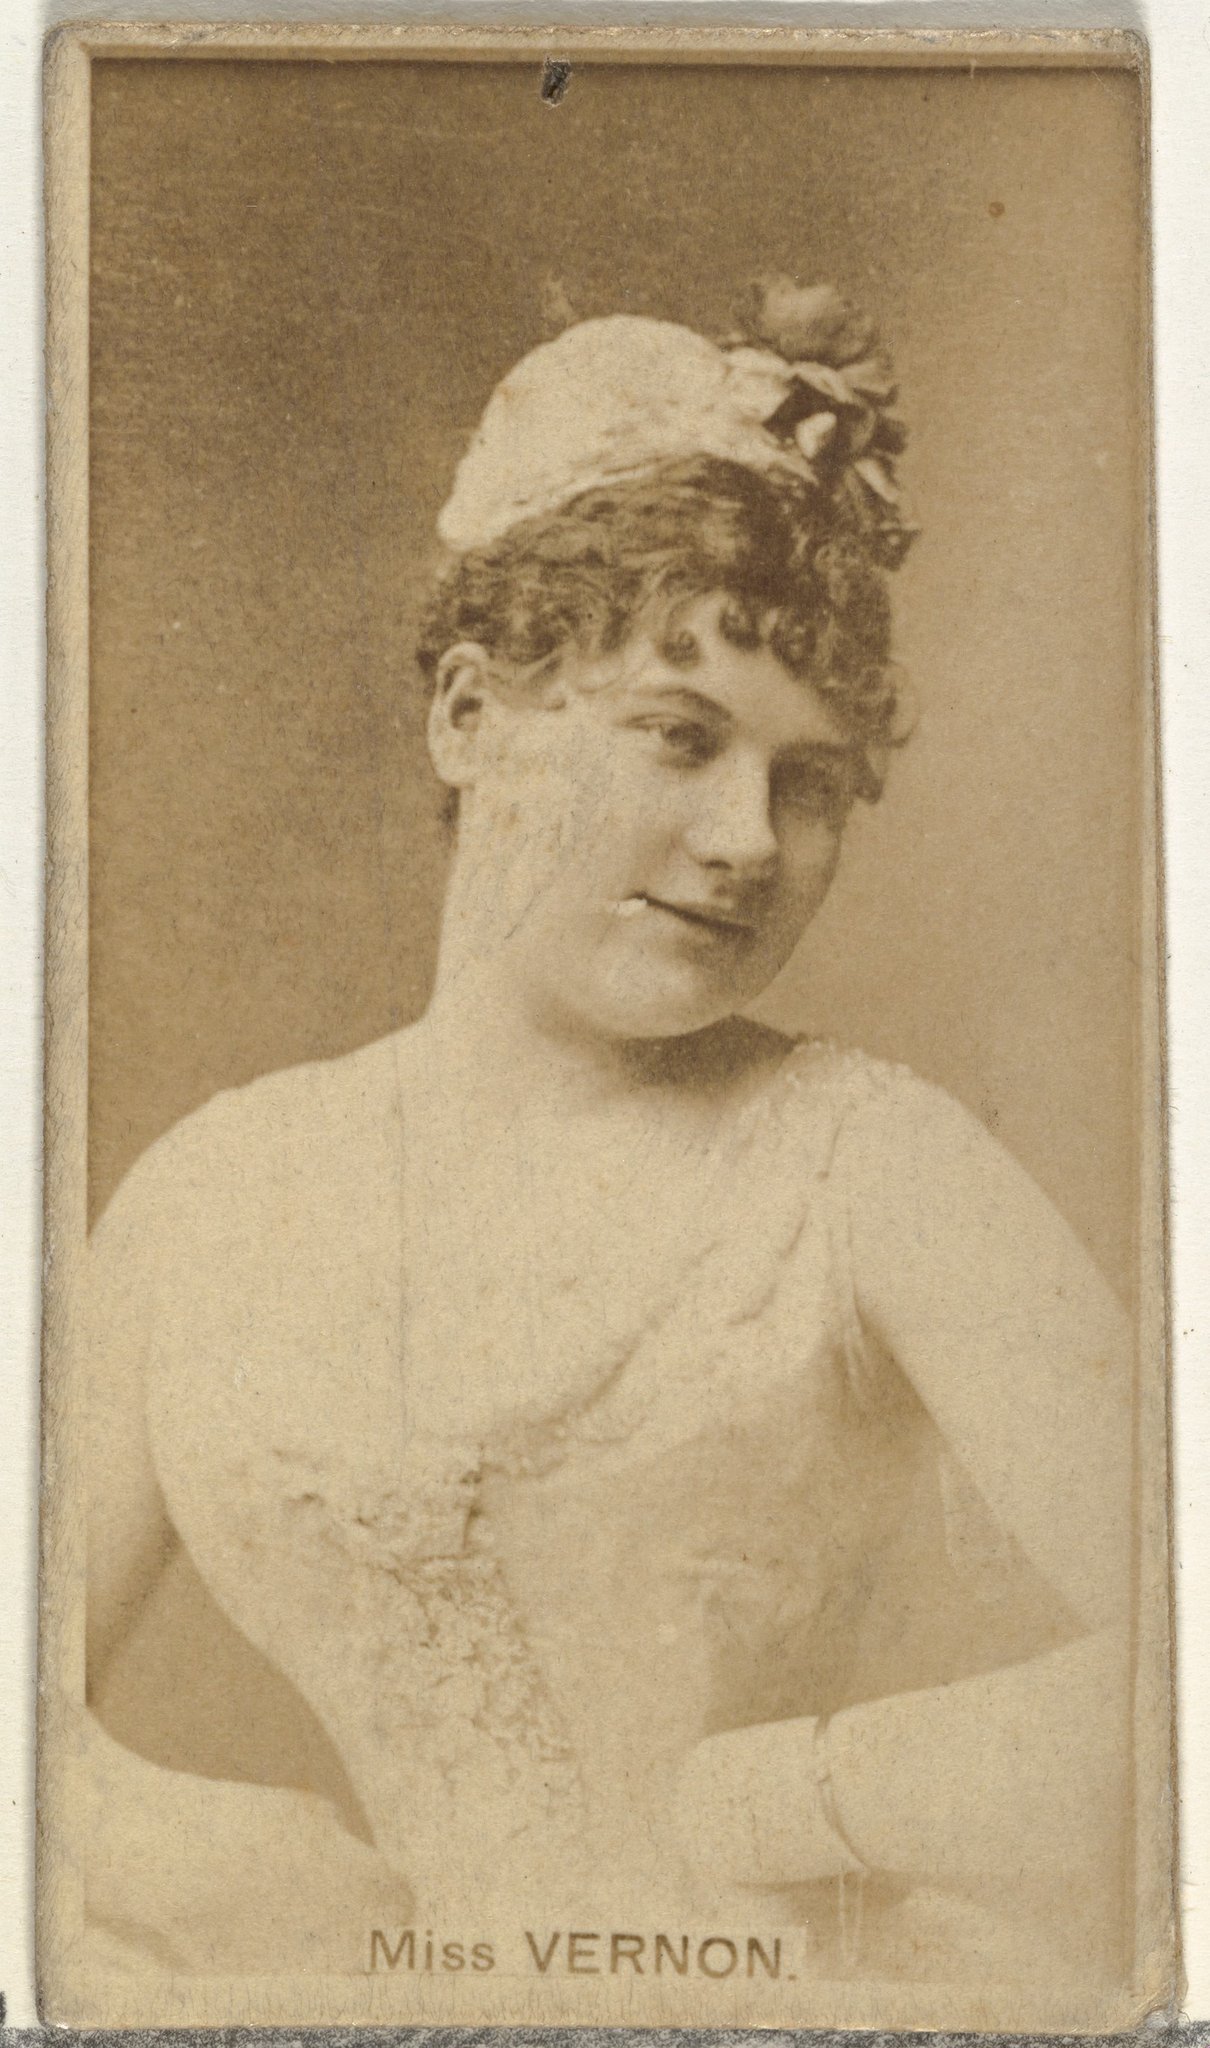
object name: photograph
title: Miss Vernon, from the Actors and Actresses series (N145-8) issued by Duke Sons & Co. to promote Duke Cigarettes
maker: w. duke, sons & co.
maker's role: publisher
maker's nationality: american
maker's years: 1870-1920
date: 1891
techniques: albumen silver print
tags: portraits,women,actresses